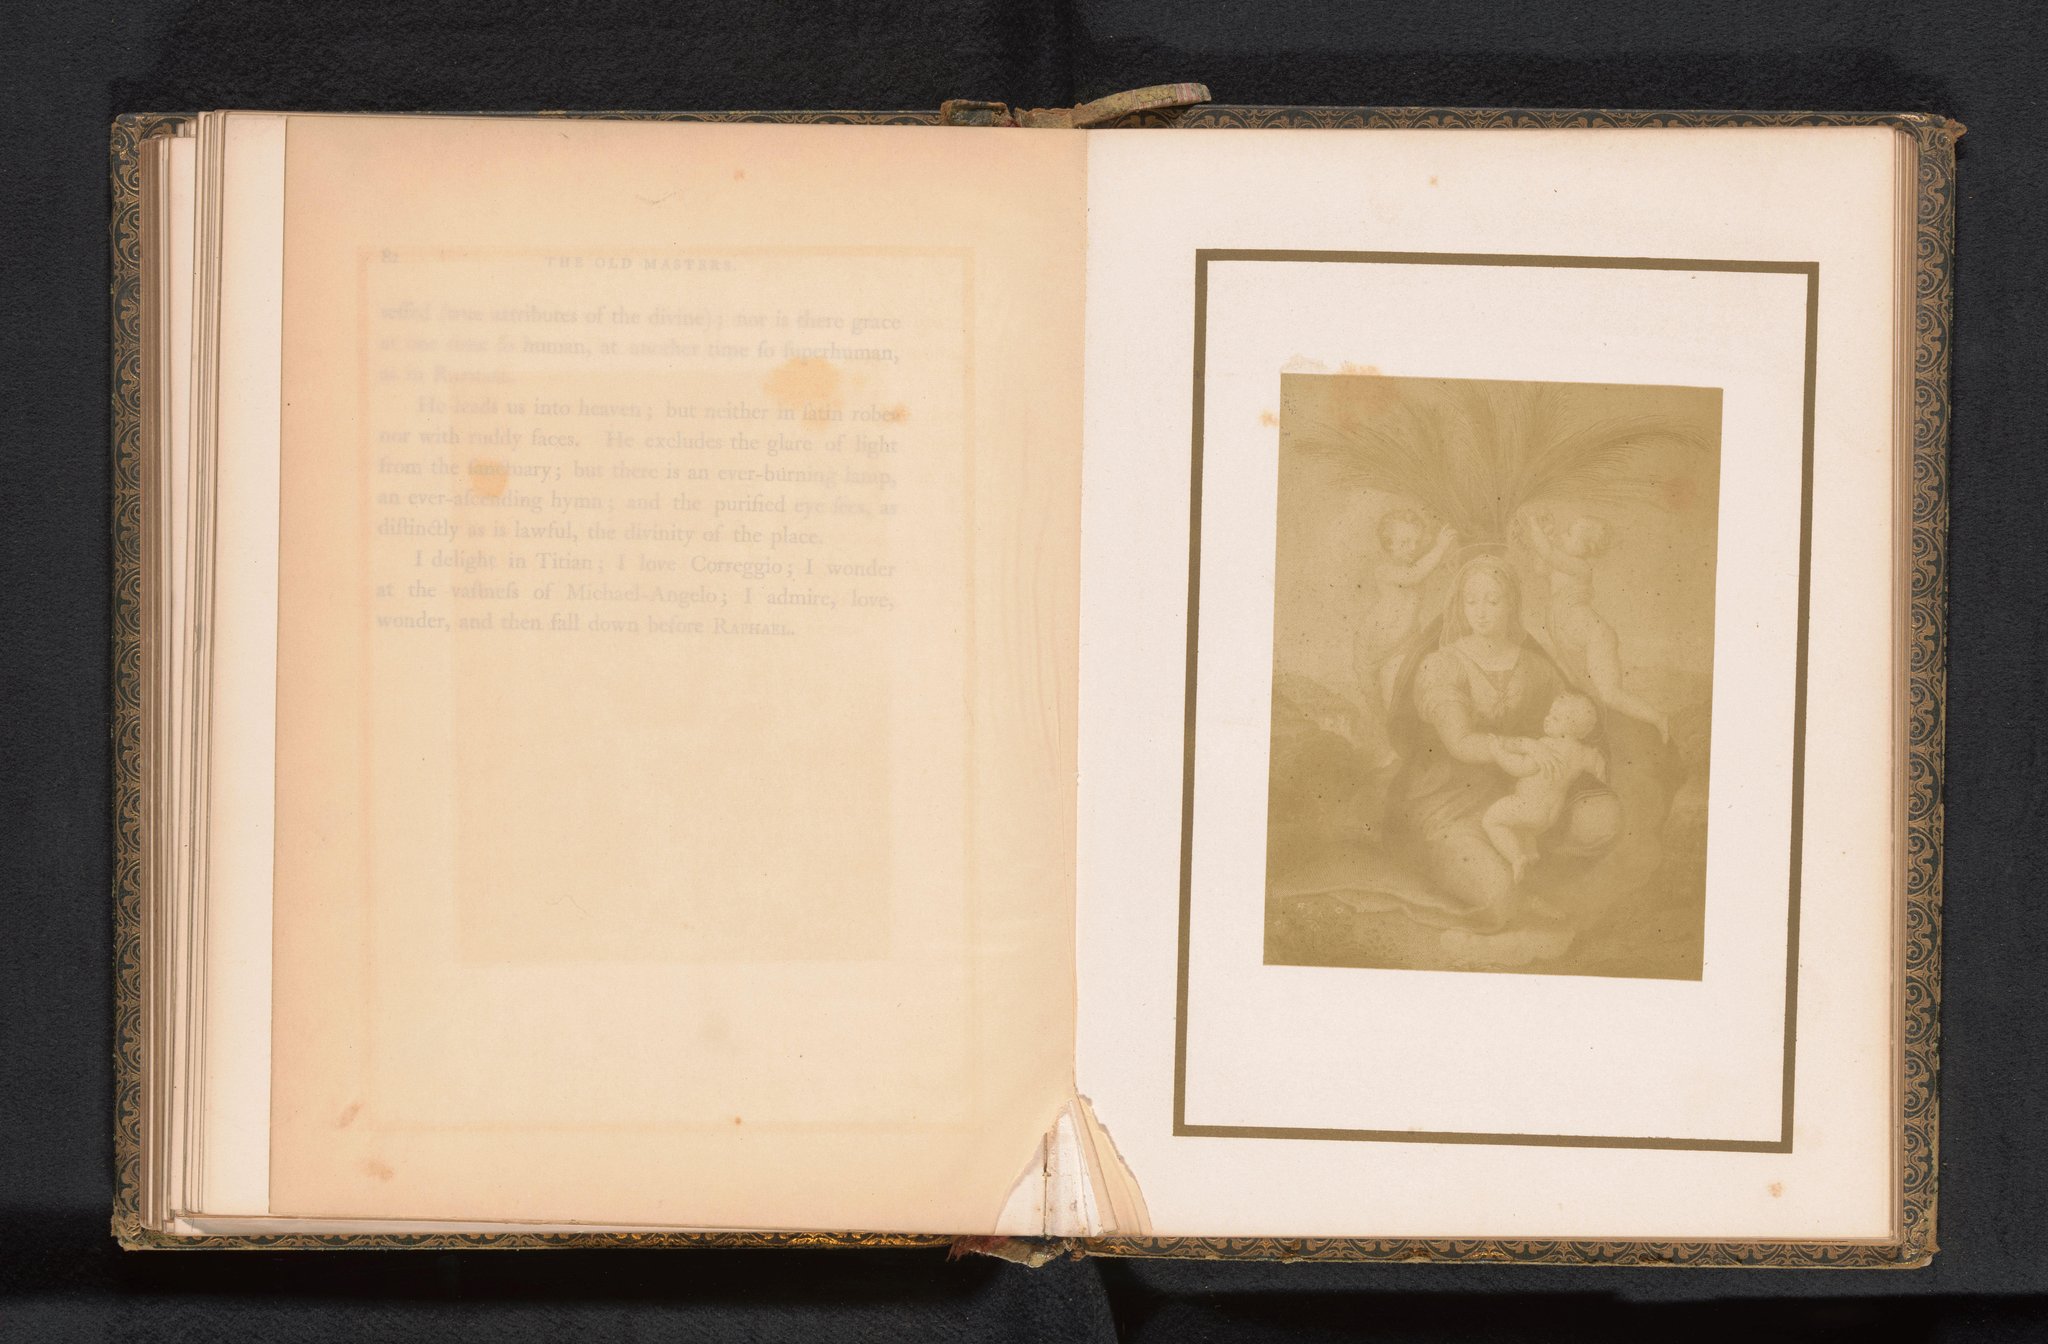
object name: reproduction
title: Fotoreproductie van een prent naar een schilderij, voorstellende Maria met Kind en putti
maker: e. hufnagel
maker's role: fotograaf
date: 1855-1860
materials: photographic support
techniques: albumen print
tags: the virgin mary, cupids: 'amores', 'amoretti', 'putti'